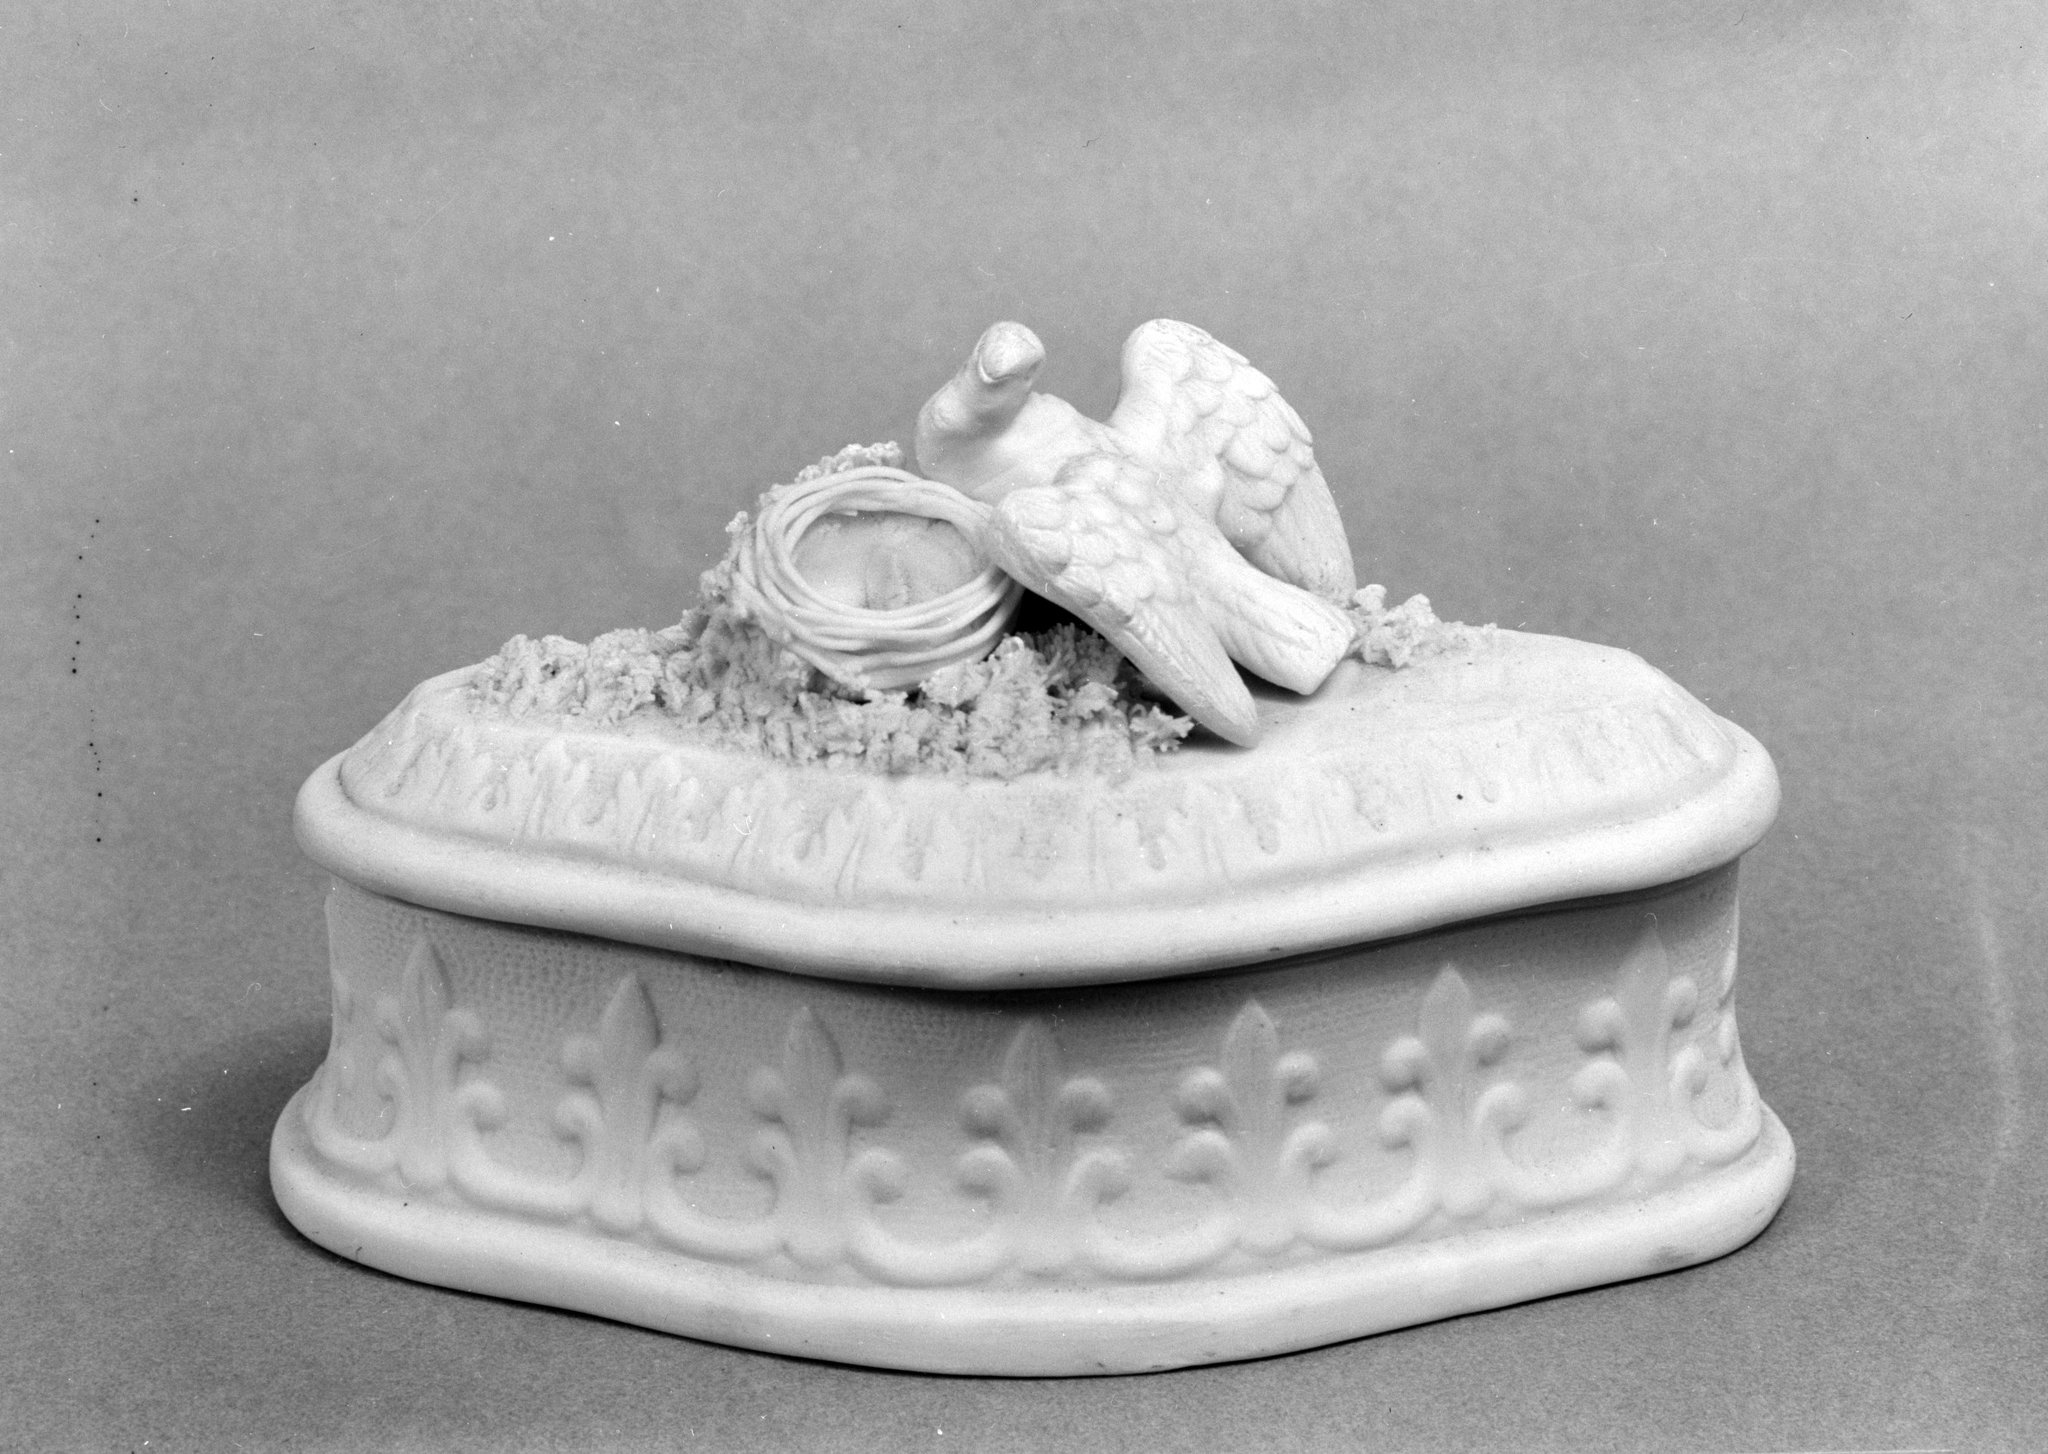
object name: box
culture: american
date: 1830-1870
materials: porcelain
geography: united states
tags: birds